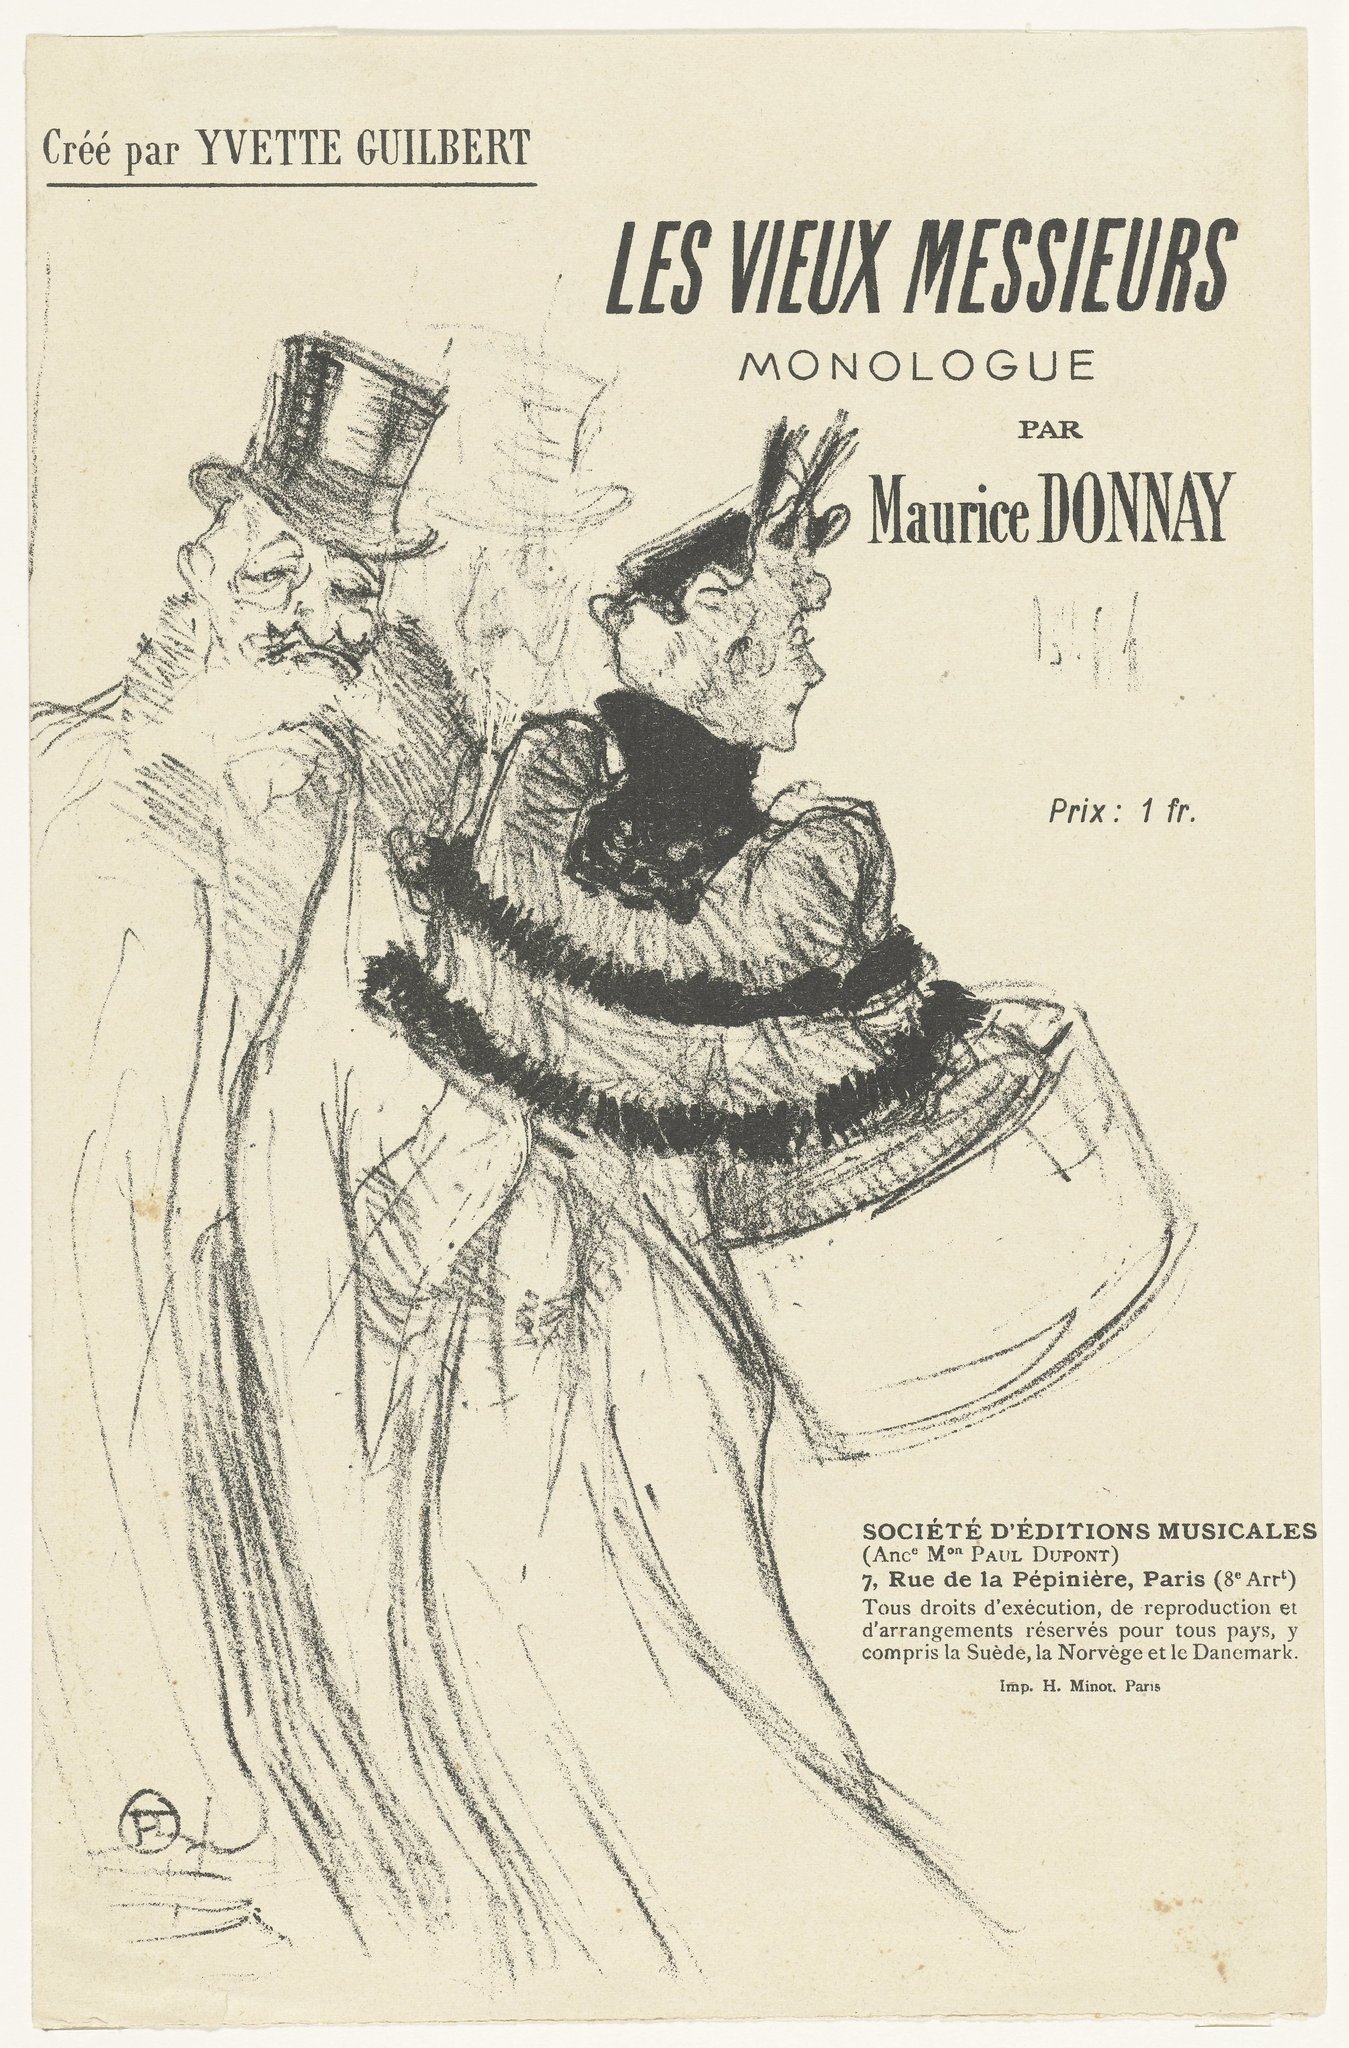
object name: print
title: Les vieux messieurs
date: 1894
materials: paper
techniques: lithograph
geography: paris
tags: female sex; woman, old man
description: Omslag van muziekblad voor de tekst van het lied Les vieux messieurs met elegant geklede vrouw met een hoedendoos aan haar arm en een oude man met hoge hoed die naar haar kijkt. De naam van zangeres Yvette Guilbert staat linksboven vermeld, zij verwierf grote bekendheid met dit lied dat werd geschreven door Maurice Donnay.